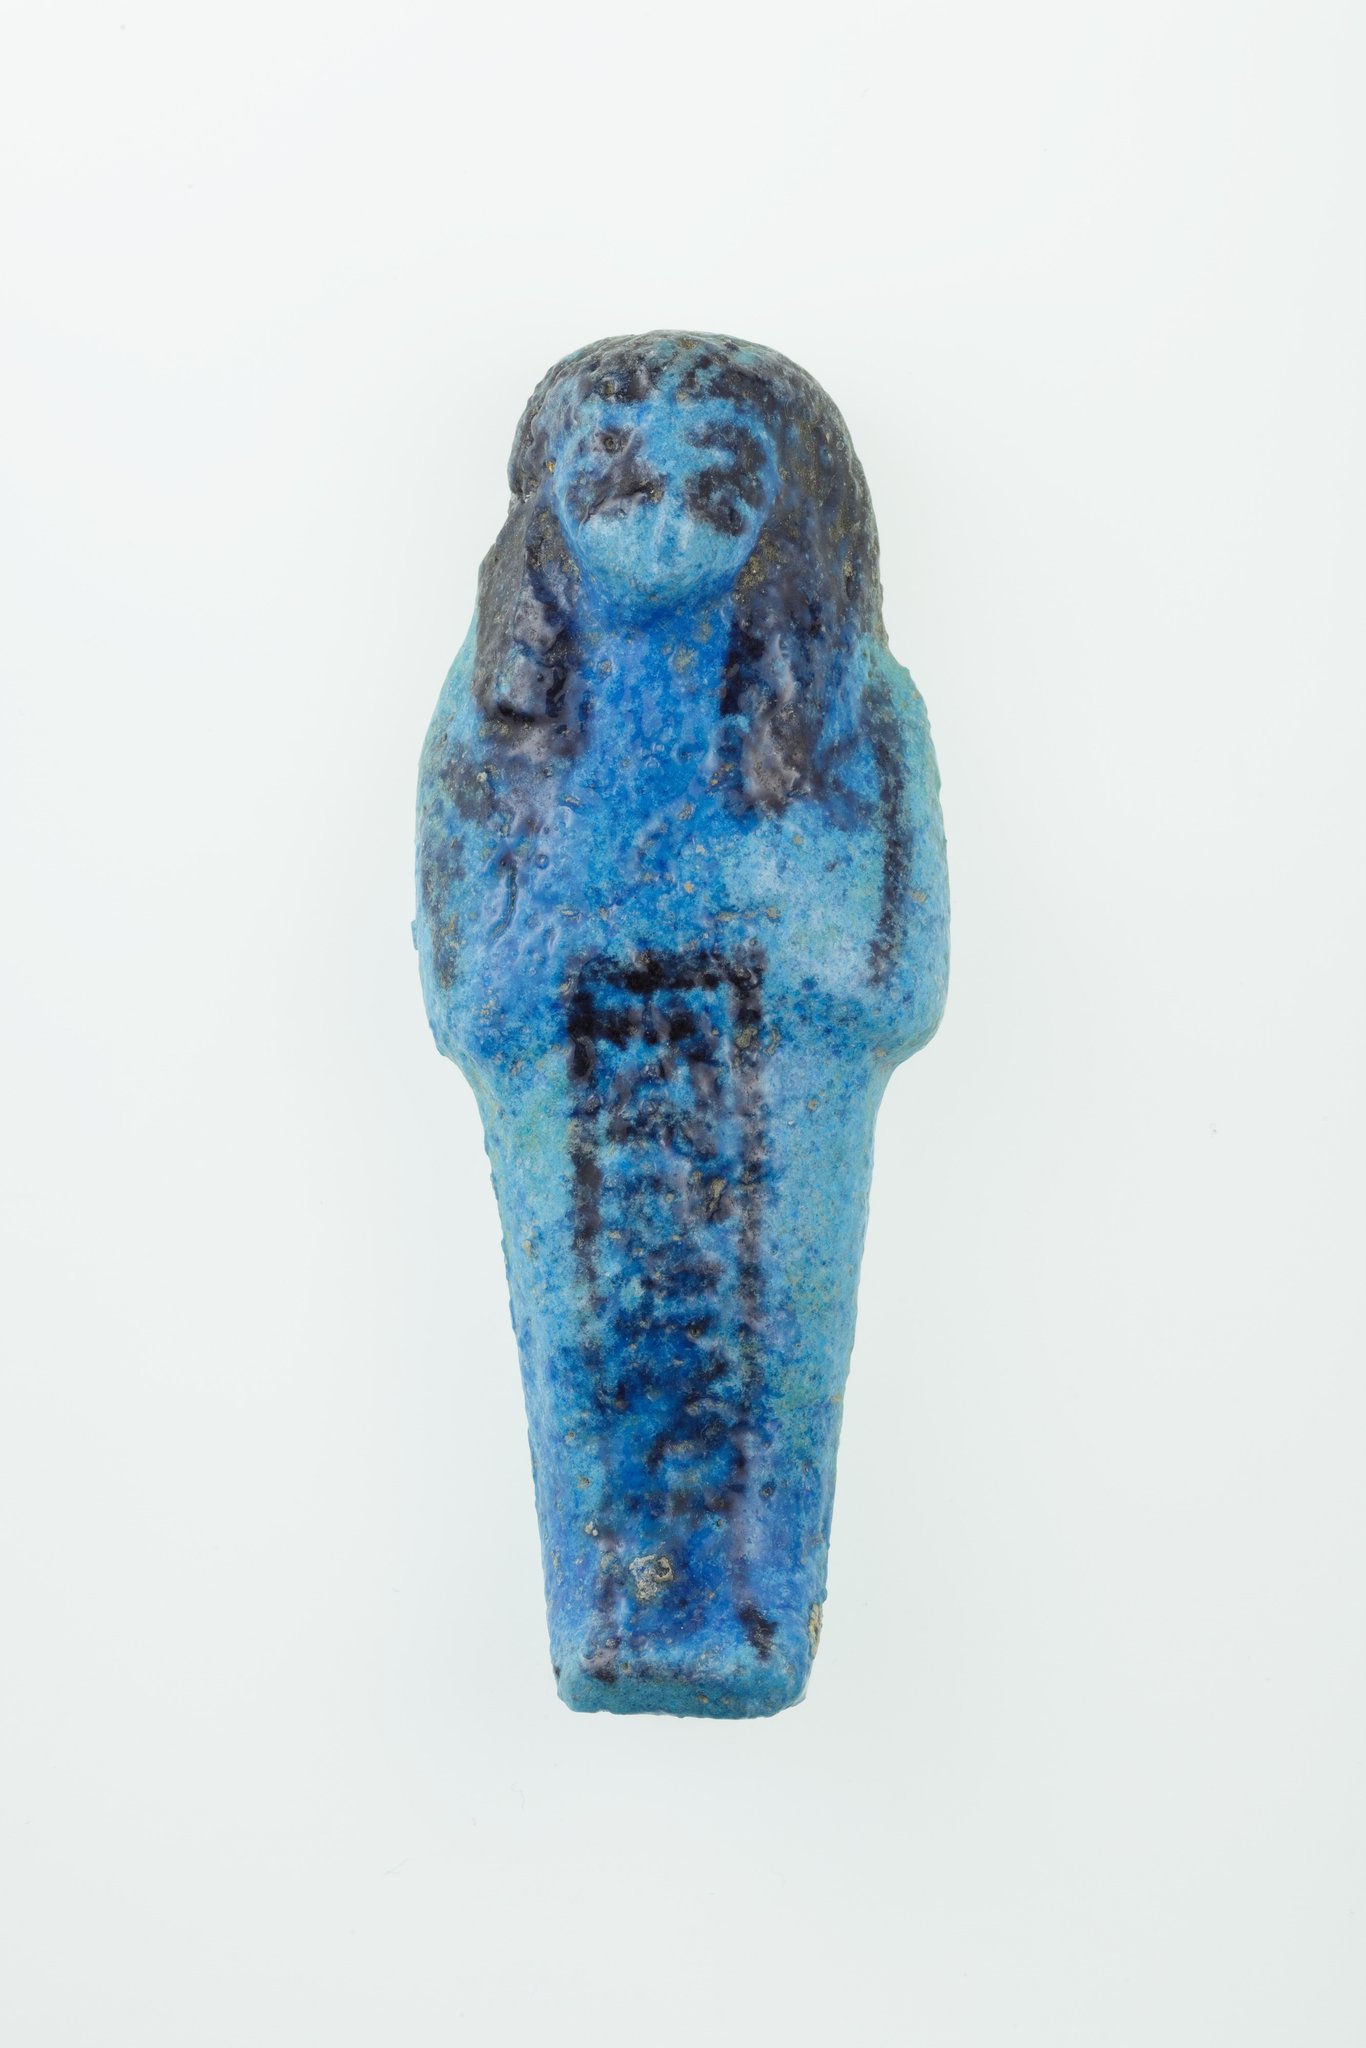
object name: shabti, worker, nauny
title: Worker Shabti of Nauny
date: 1050 BCE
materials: faience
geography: egypt